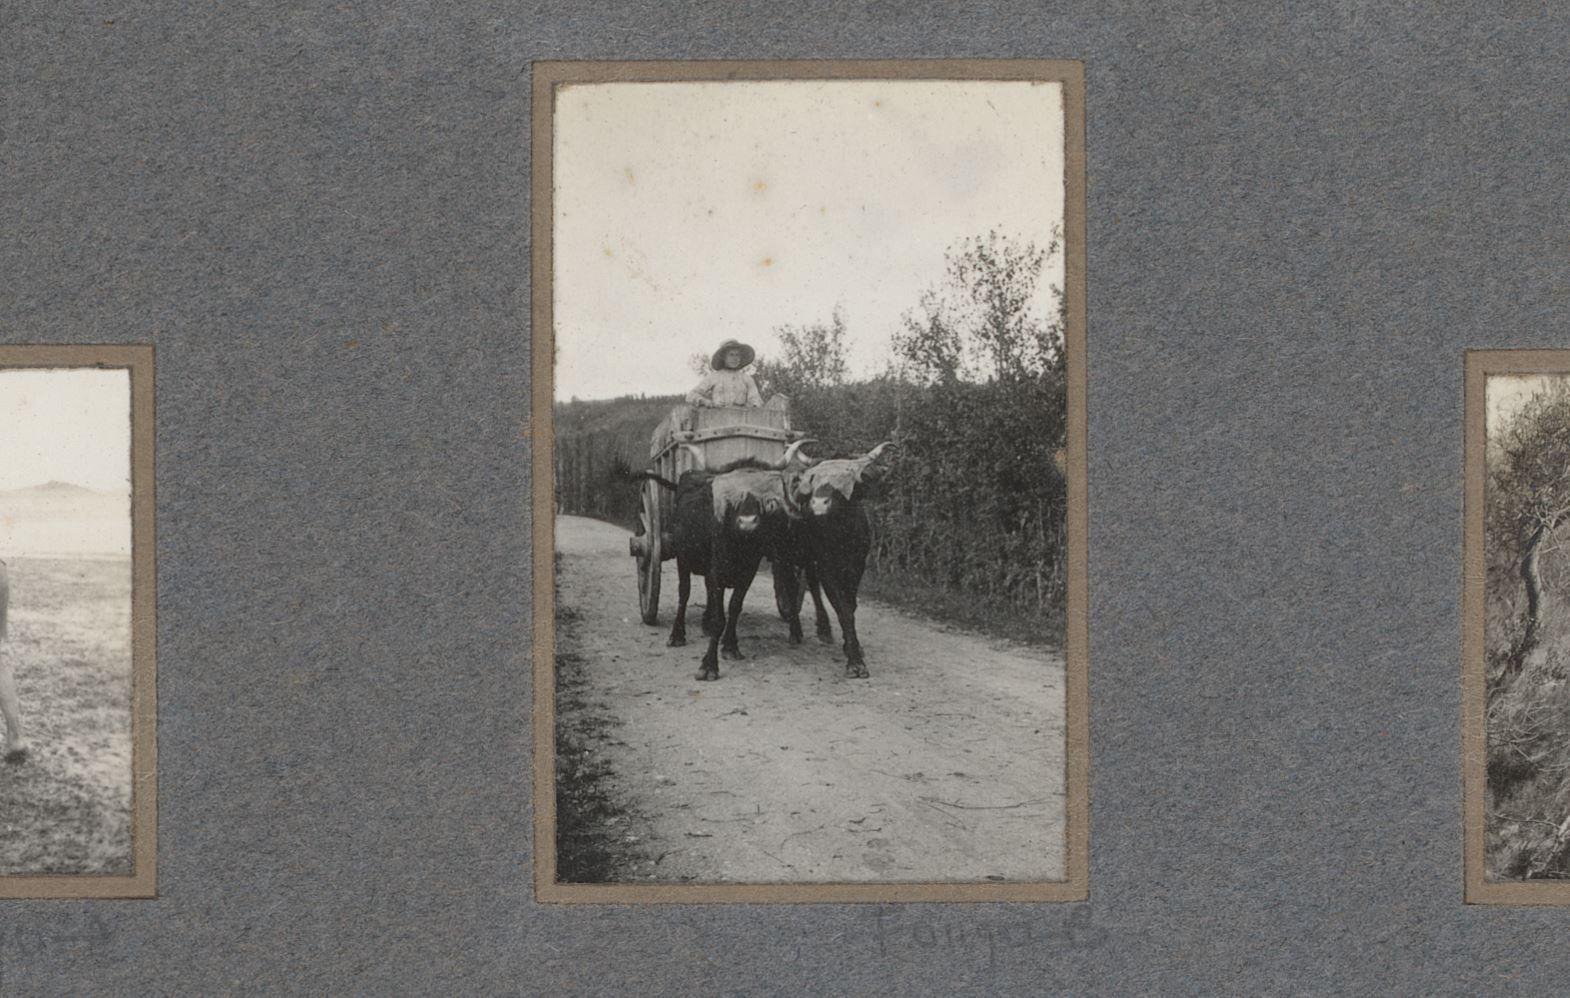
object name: photograph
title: Ossenkar op landweg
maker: Anonymous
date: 1914-1935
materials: photographic support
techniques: gelatin silver print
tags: ox, (farm) wagon, freight wagon, cart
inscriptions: inscription: ‘Opnamen gemaakt met de "Brownie" No.0./ Afdrukken gemaakt op "Velox" papier.’